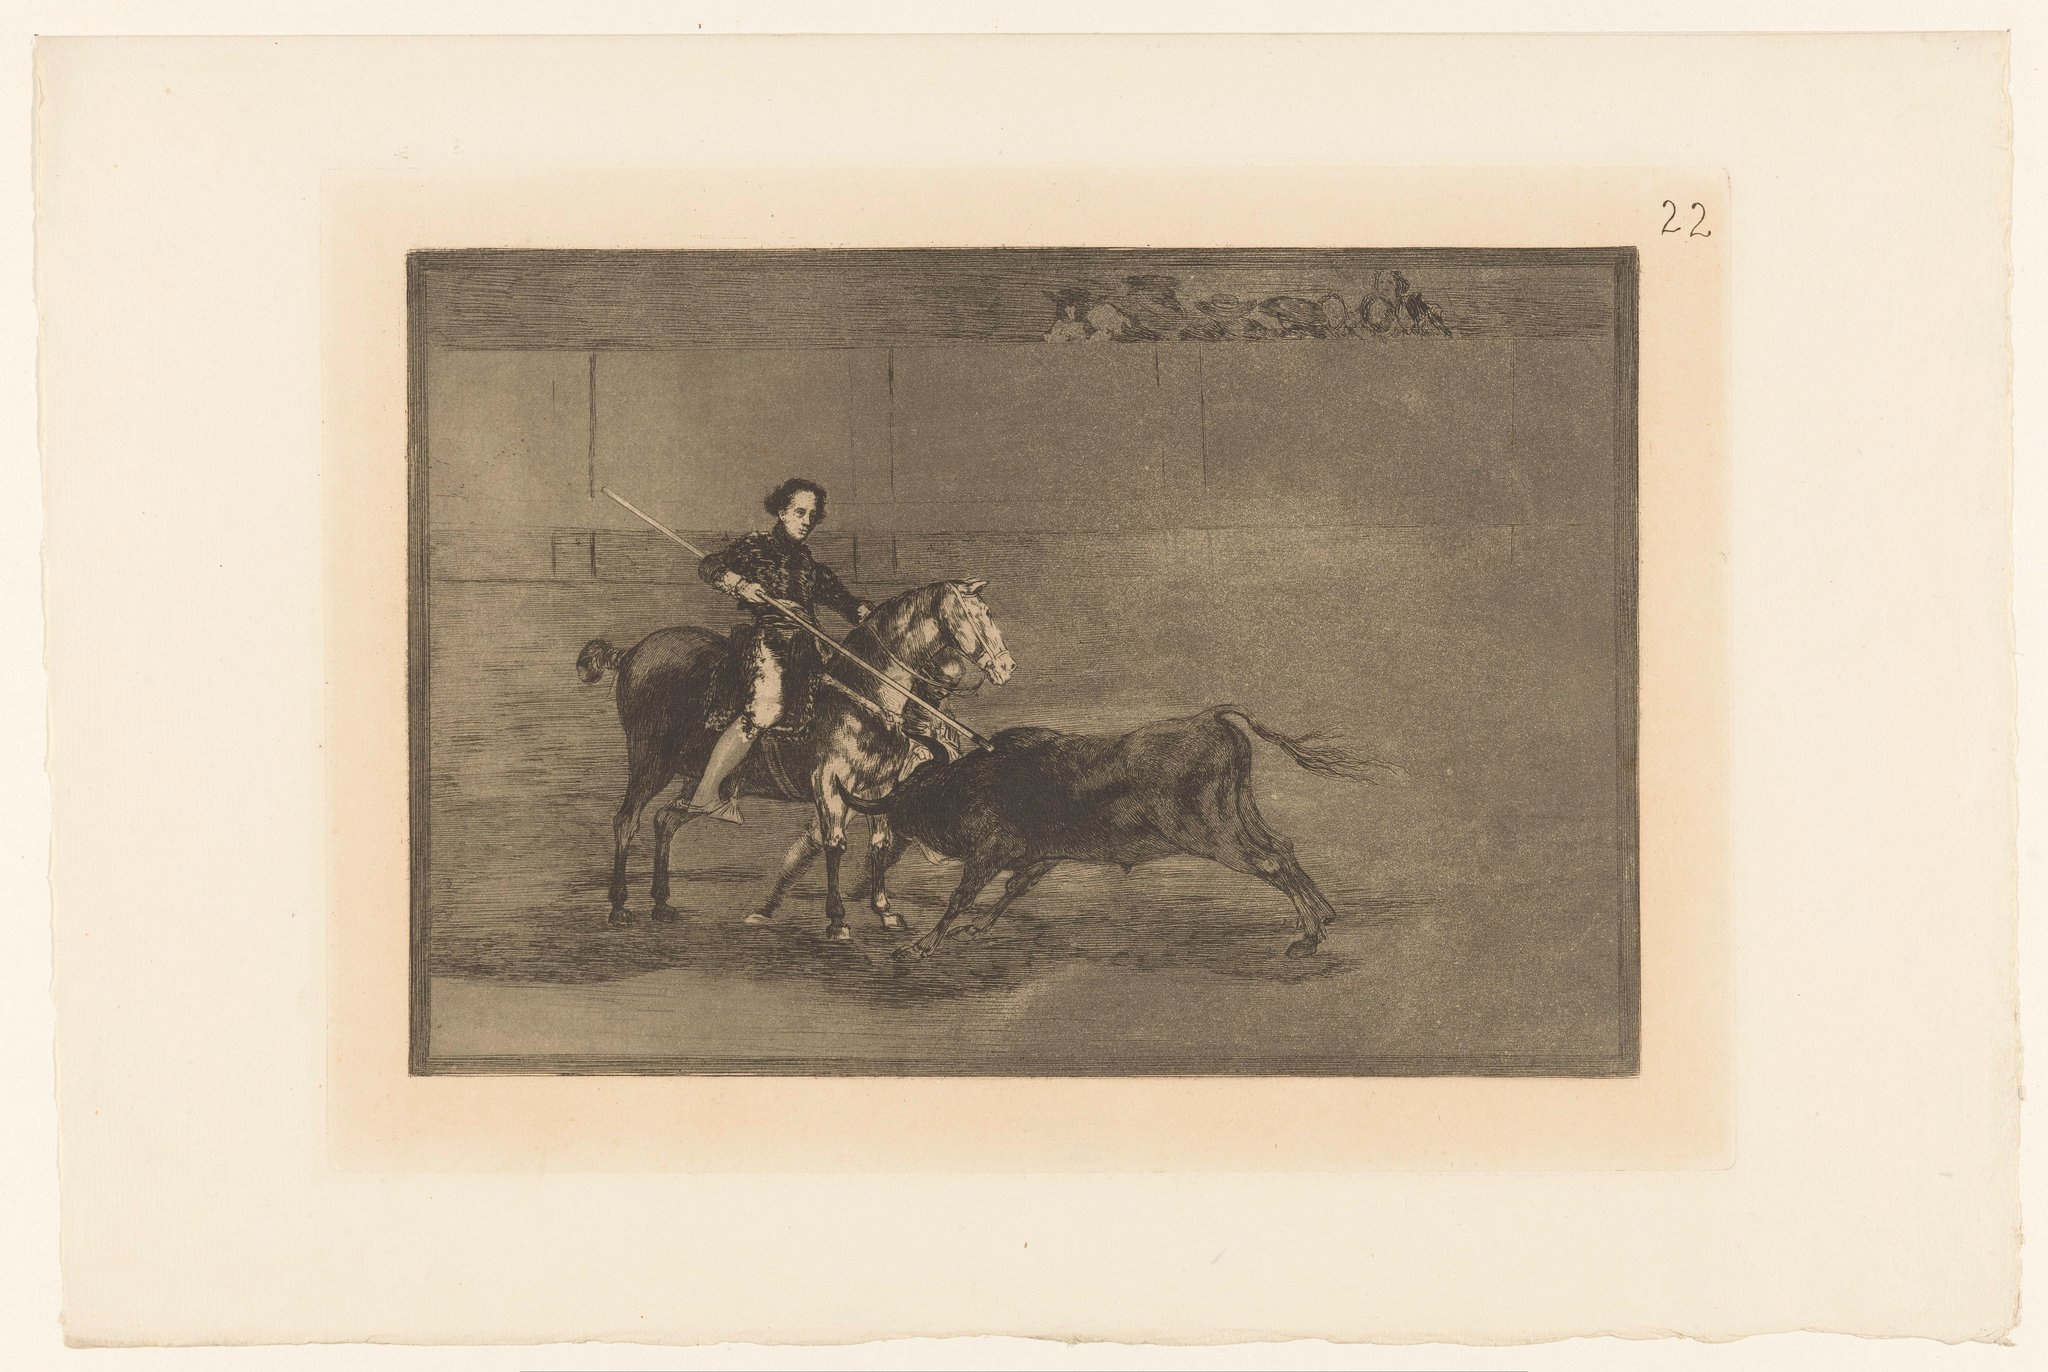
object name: print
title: Pajuelera in de arena van Zaragosa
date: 1876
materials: paper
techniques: aquatint, etching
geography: paris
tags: bullfight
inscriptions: collector's mark: Lugt 2228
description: Deze prent maakt deel uit van een serie van 40 prenten door Francisco de Goya met voorstellingen van stierengevechten. De eerste editie bestond uit 33 genummerde prenten en werd uitgegeven in 1816. Dit betreft de derde editie, uitgegeven in 1876 door Eugène Loizelet en door hem voorzien van een titelprent en lijst met titels. Naast de 33 prenten publiceerde Loizelet ook de prenten die door Goya op de achterkanten van 7 van de platen werden geëtst. Deze zijn niet voorzien van nummers maar van de letters A-G.